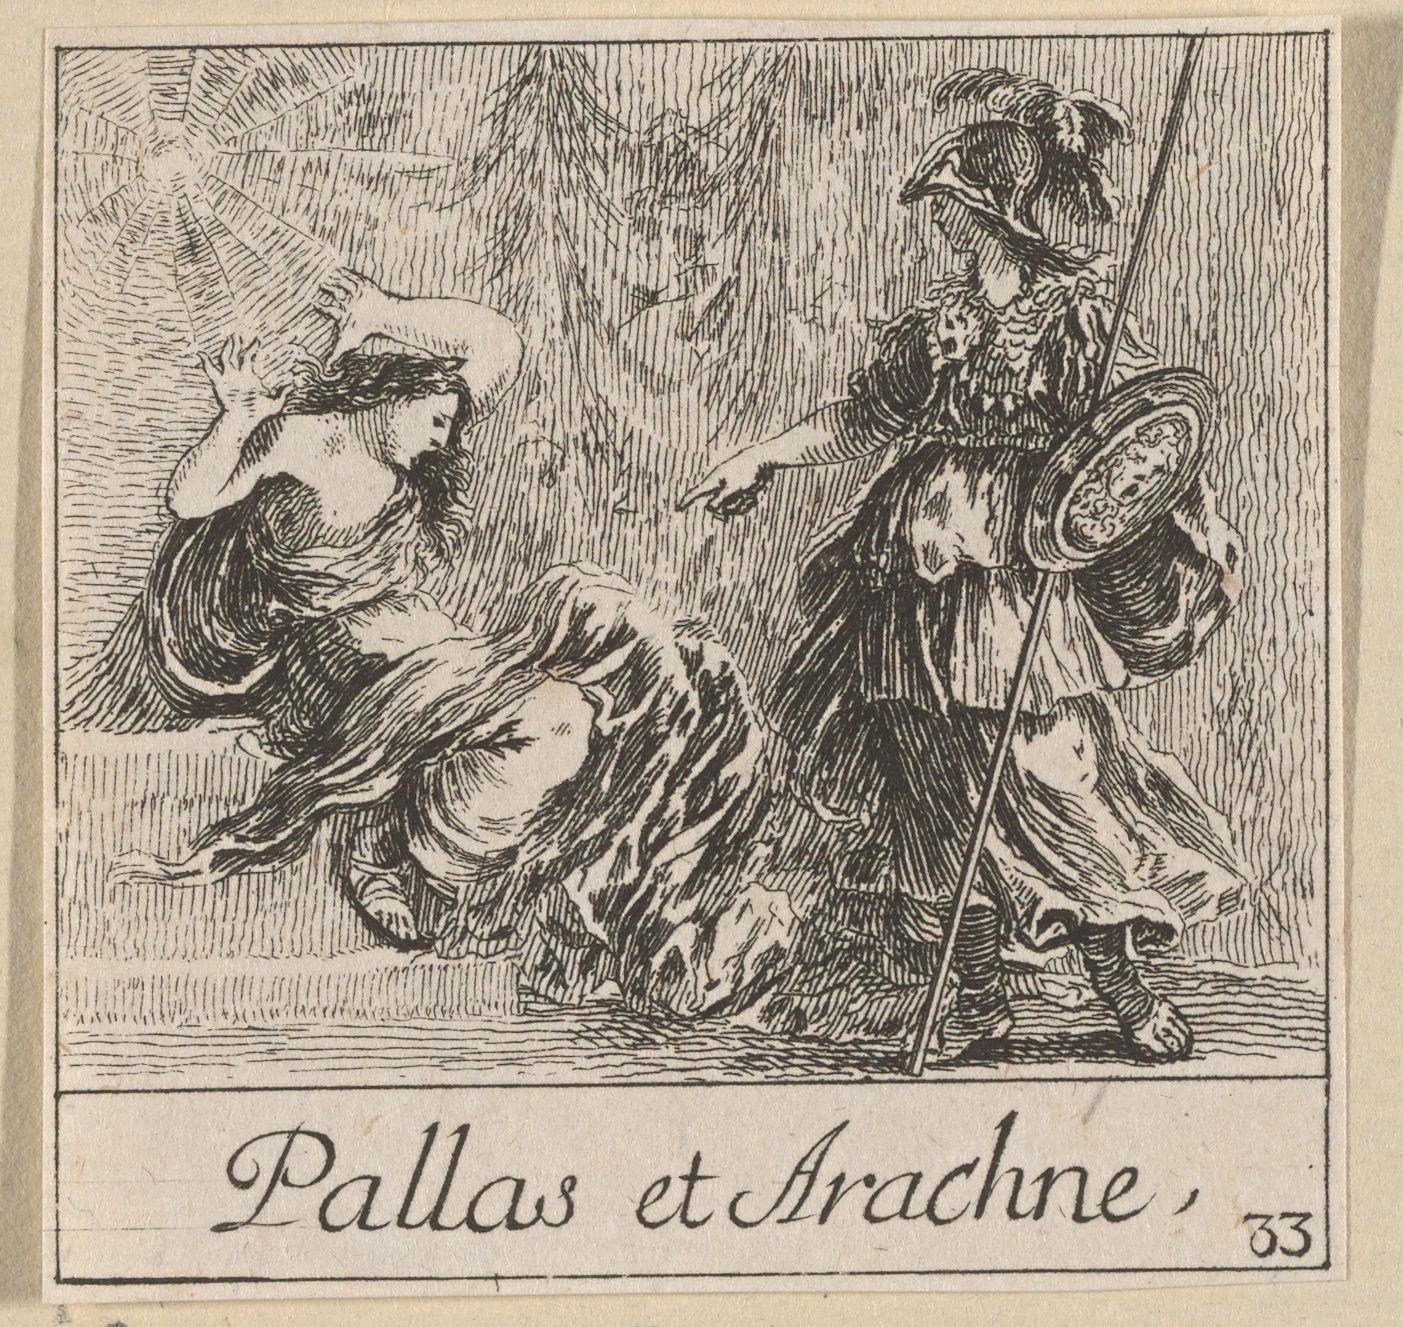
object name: playing card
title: Pallas et Arachne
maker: Anonymous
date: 1620-1664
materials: paper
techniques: etching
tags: arachne challenges minerva to a weaving contest (arachne as yet not metamorphosed)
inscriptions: collector's mark: Lugt 240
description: Prent uit een reeks van 54 genummerde speelkaarten met voorstellingen uit de Metamorfosen van Ovidius.